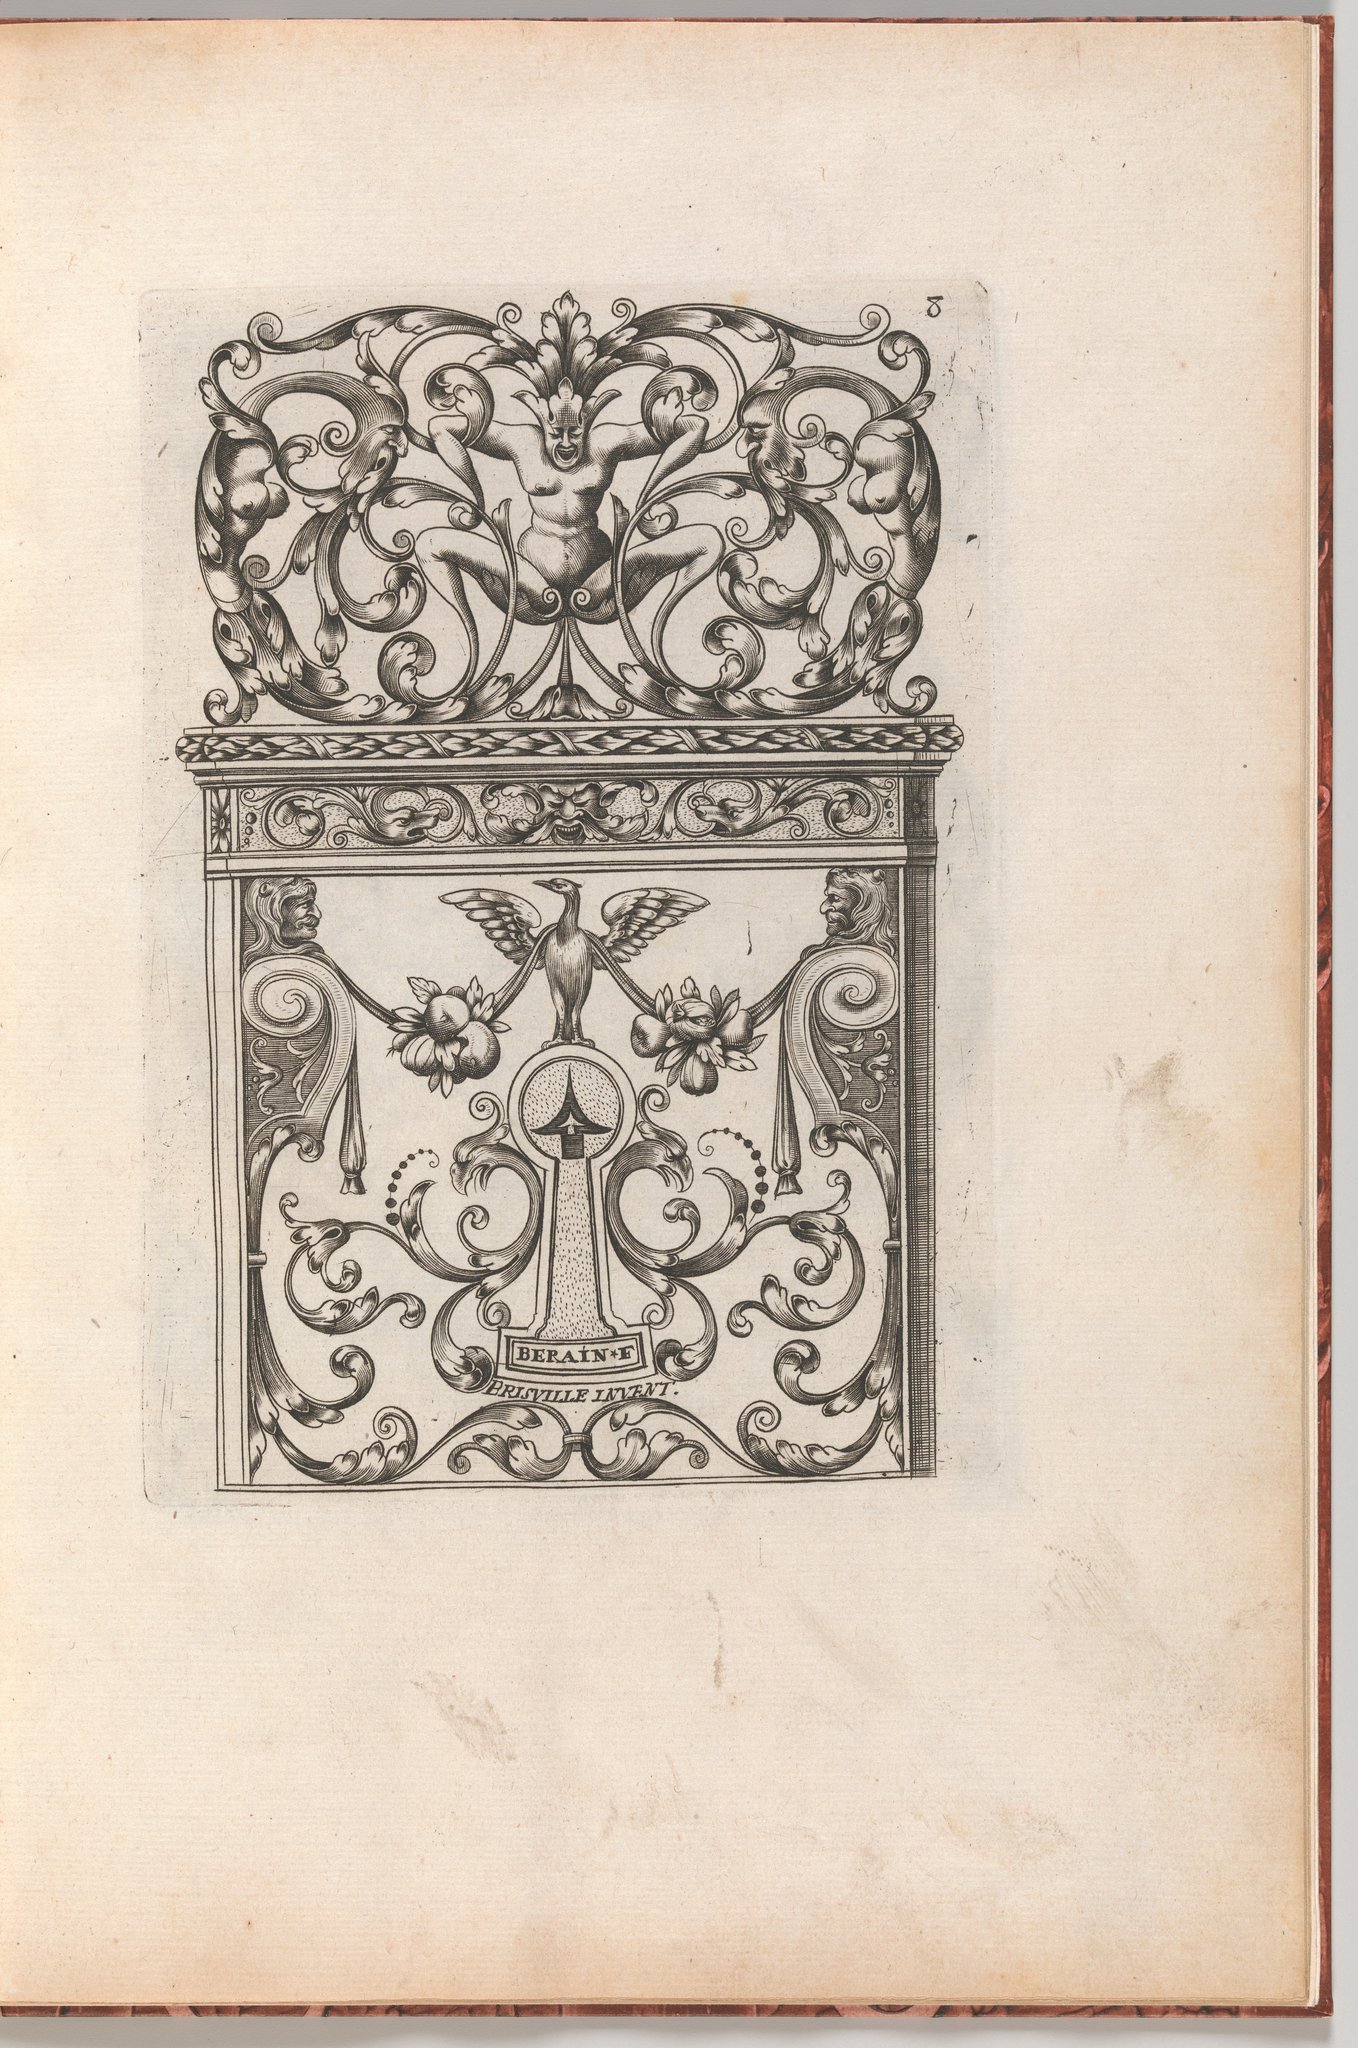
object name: album print ornament architecture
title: Diverses Pieces de Serruriers, page 9 (recto)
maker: jean berain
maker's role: artist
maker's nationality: french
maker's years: 1640-1711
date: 1663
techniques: engraving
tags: birds,ornament